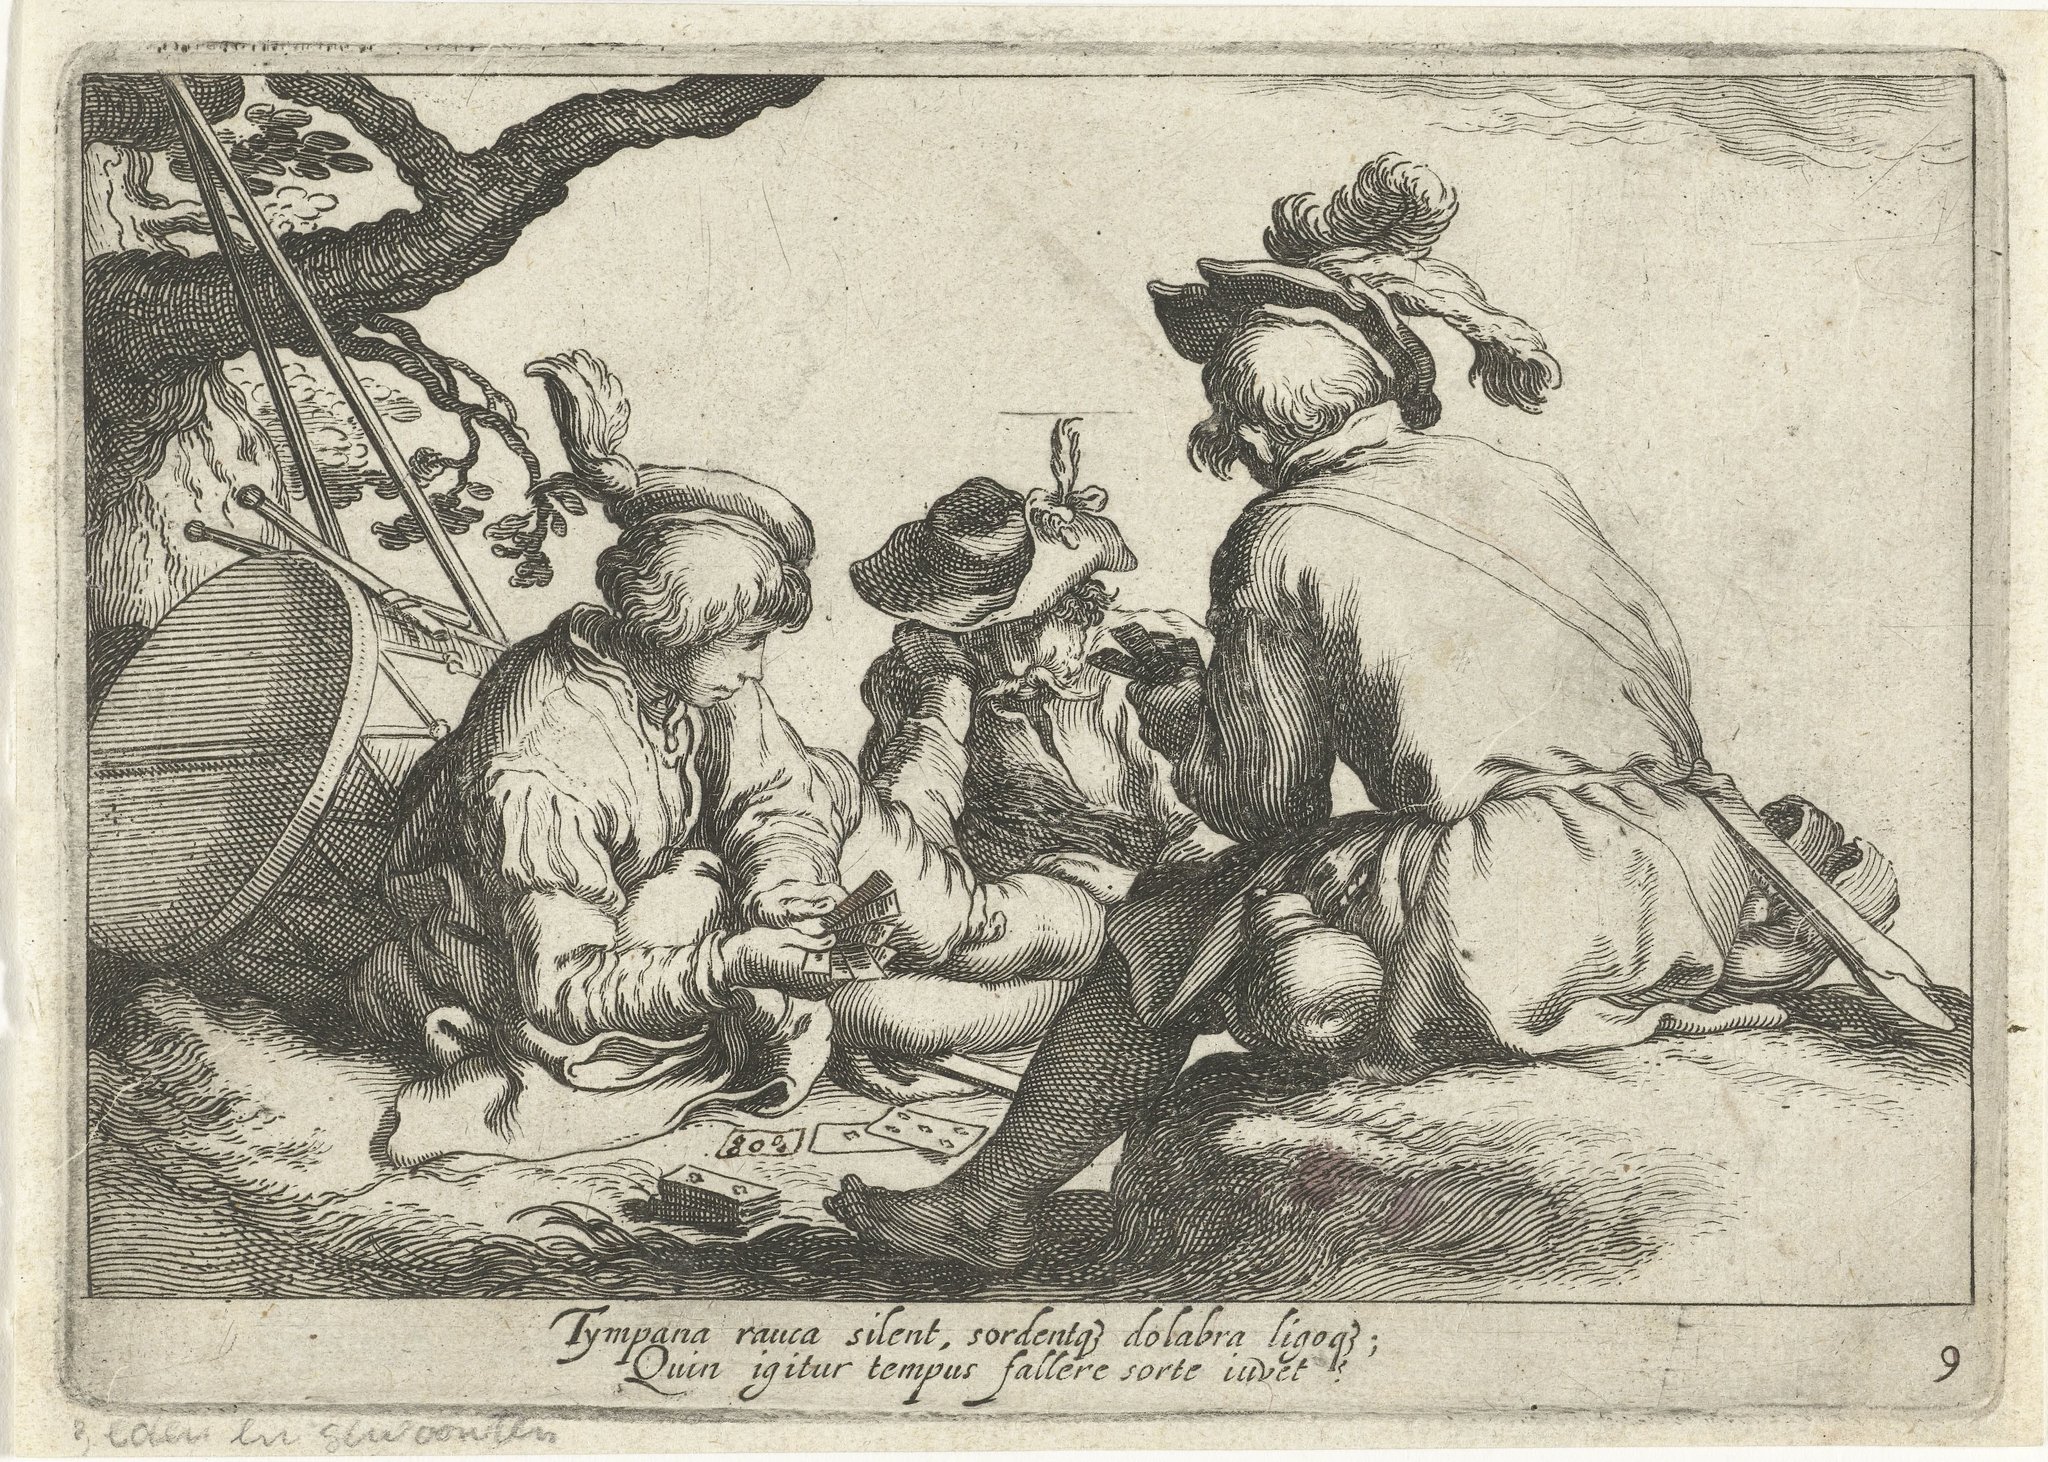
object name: print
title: Kaartspelende soldaten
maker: cornelis bloemaert (ii)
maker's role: draughtsman, print maker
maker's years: 1603-1692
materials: paper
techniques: engraving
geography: utrecht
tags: pastorals, arcadian scenes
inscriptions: collector's mark: Lugt 2233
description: Drie soldaten spelen onder een boom een kaartspel. Met tweeregelig Latijns onderschrift.